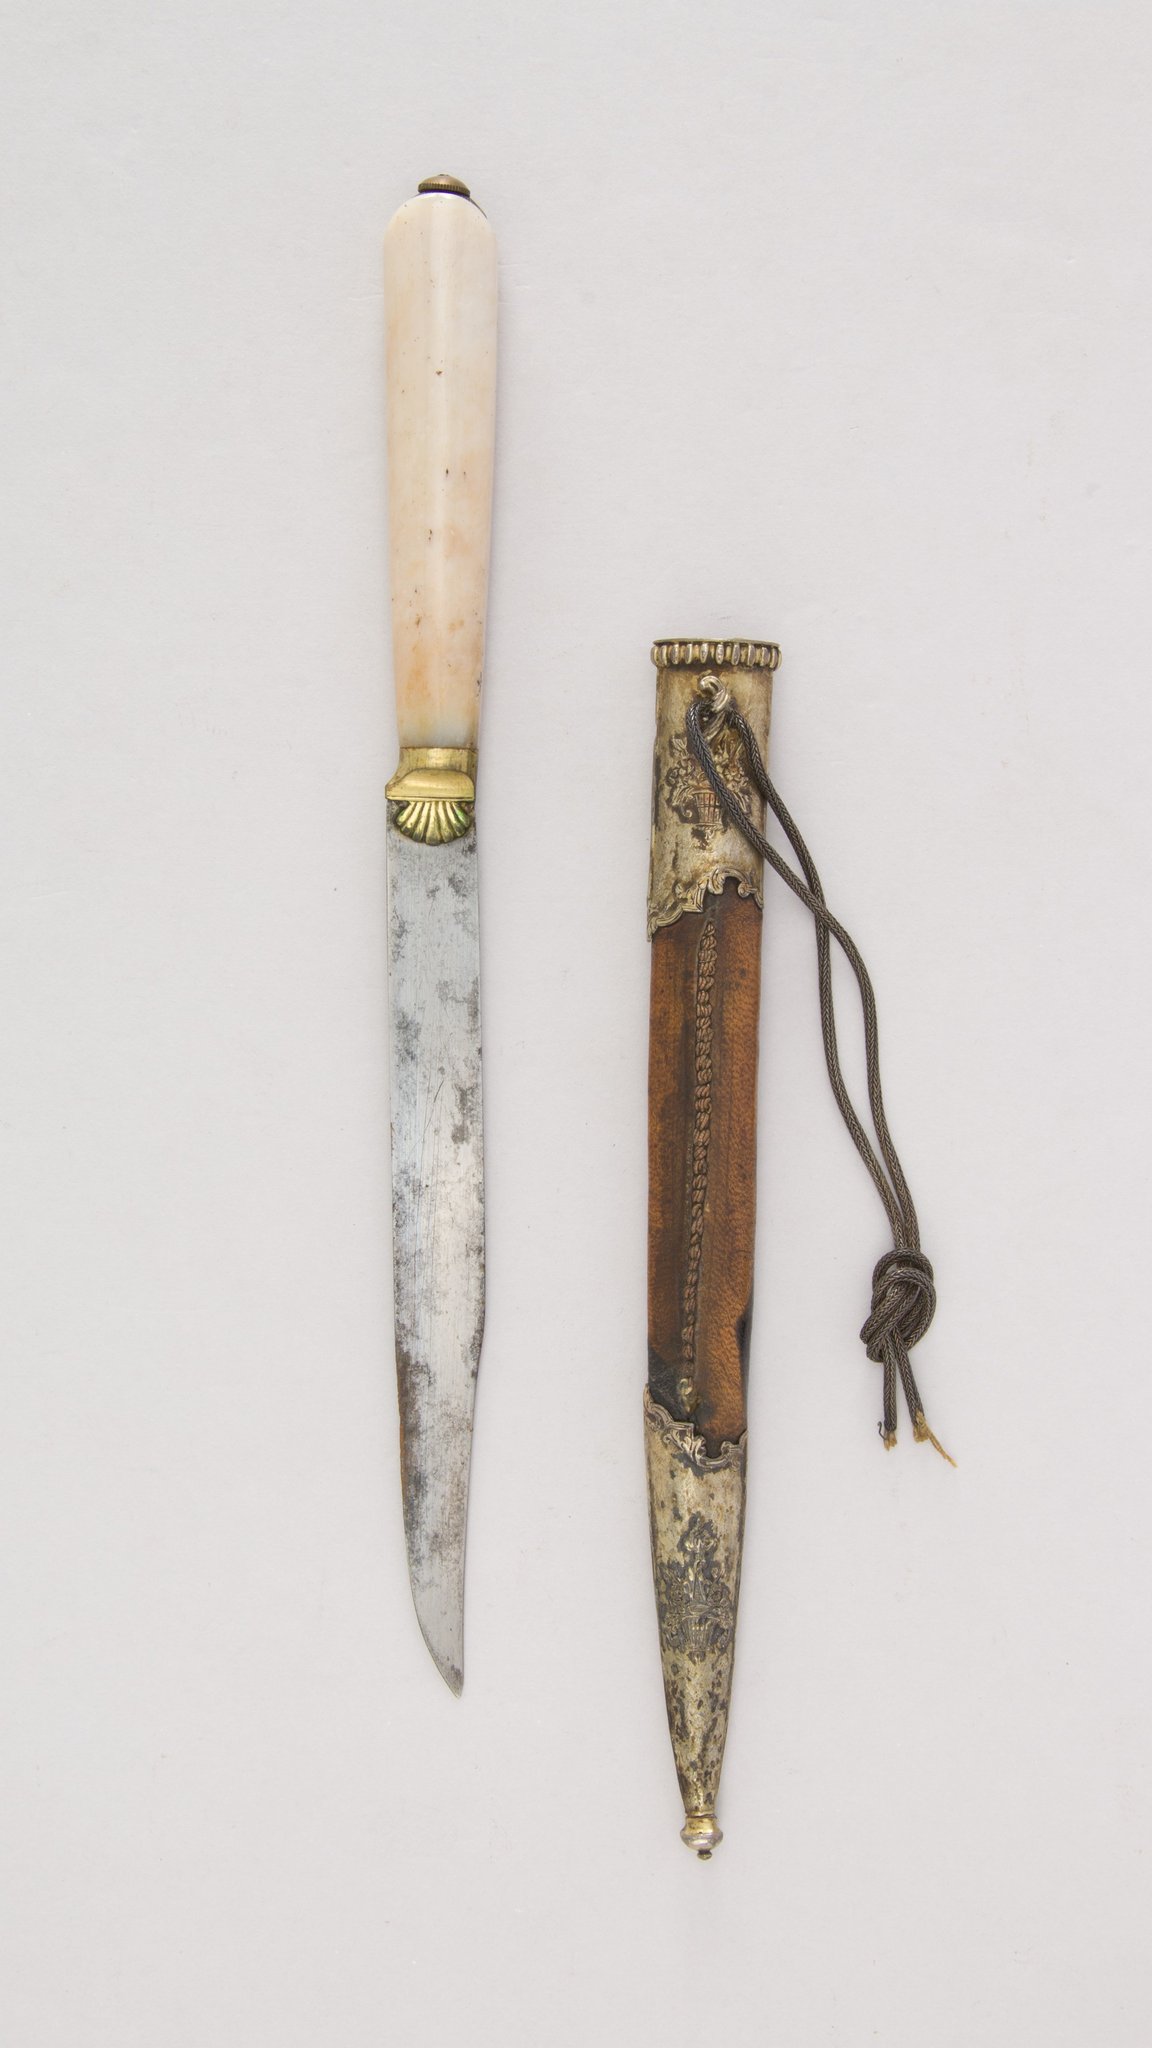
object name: knife with sheath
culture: turkish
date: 1701-1900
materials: stone, leather, silk, silver, steel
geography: turkey